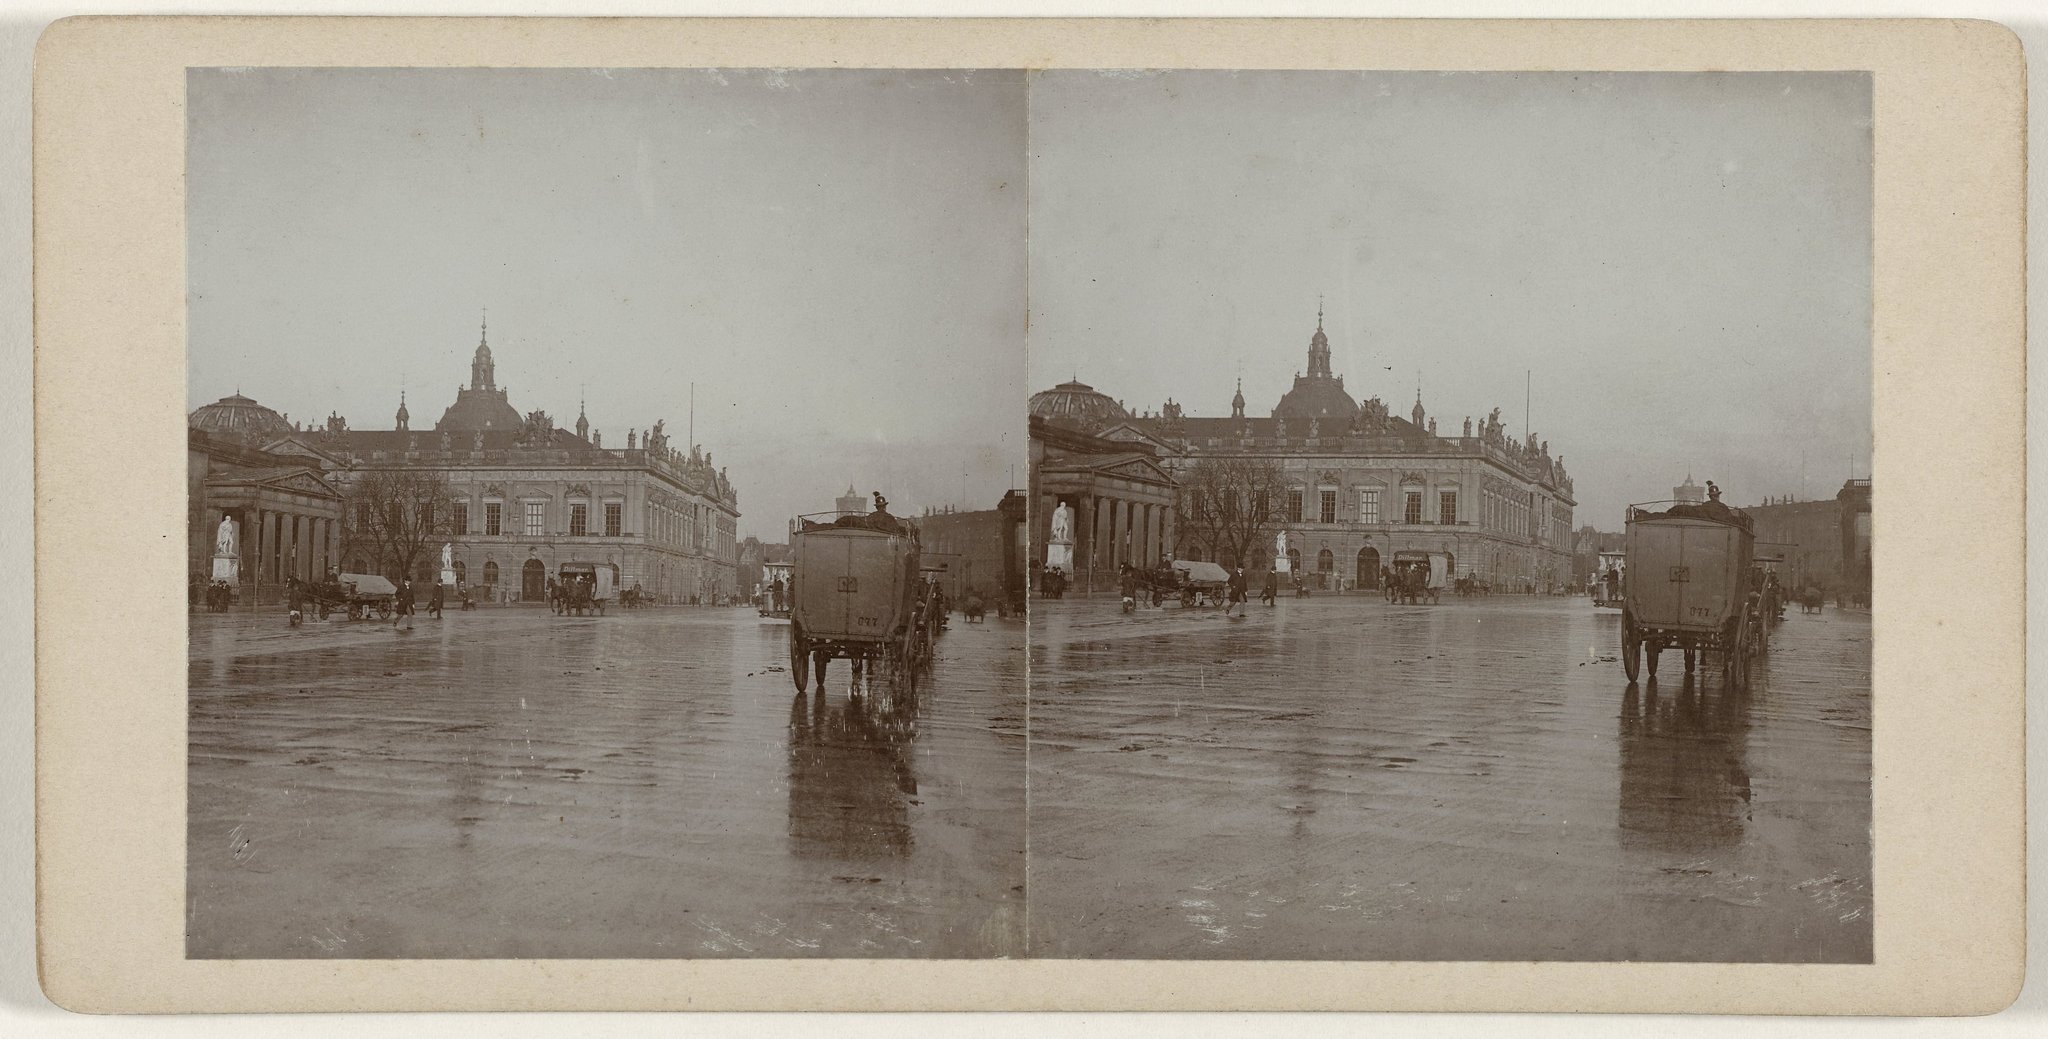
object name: stereograph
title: Unter den Linden met Neue Wache, Berlijn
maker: geldolph adriaan kessler (dolph)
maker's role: fotograaf, industrieel, voetballer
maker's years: 1884-1945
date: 1903-1910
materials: cardboard, paper, photographic support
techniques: collodion silver print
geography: berlin